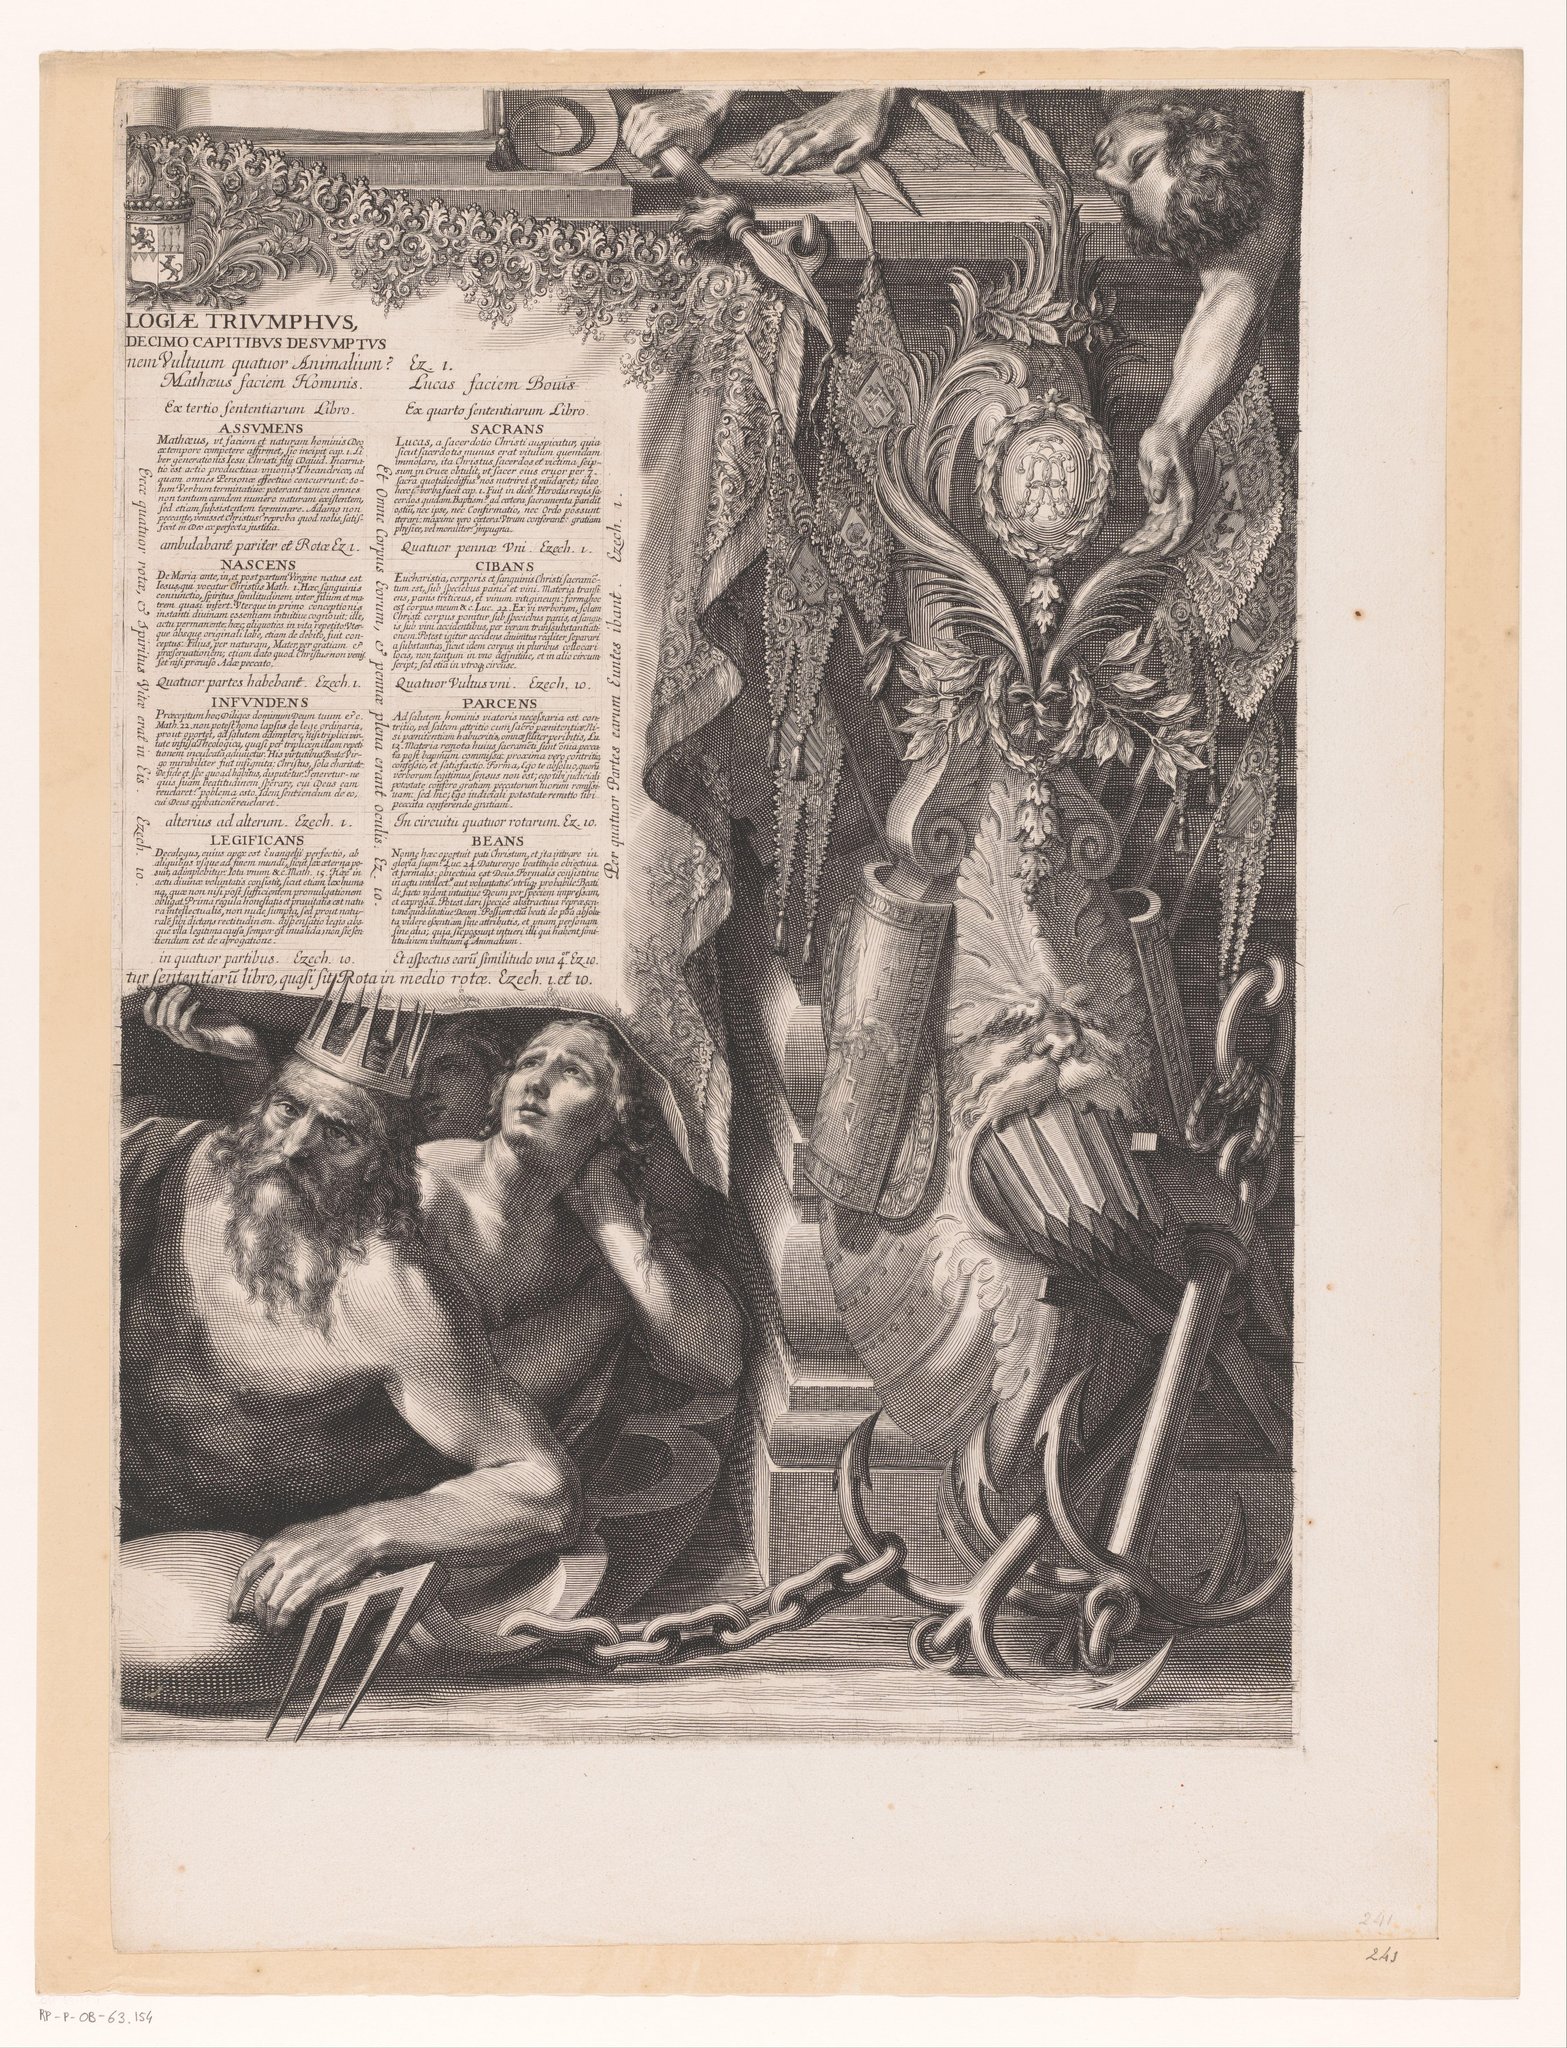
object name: print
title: Allegorische voorstelling met Armand-Jean du Plessis hertog van Richelieu, in het gezelschap van Apollo en Neptunus (deel rechtsonder)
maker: grégoire huret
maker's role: print maker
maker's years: 1606-1670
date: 1616-1670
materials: paper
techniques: engraving, etching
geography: france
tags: paris, armand-jean du plessis hertog van richelieu, (story of) neptune (poseidon), offspring, companion(s), train etc. of neptune, historical persons, armorial bearing, heraldry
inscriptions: collector's mark: Lugt 240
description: Rechter onderzijde van een allegorische voorstelling met linksboven het portret van Armand-Jean du Plessis hertog van Richelieu, gezeten op een stoel met rechts van hem muzen of nimfen die hem verschillende wapenschilden aanreiken. In het midden staat Apollo met zijn lier met achter hem een doorkijk naar buiten, waar de mast van een schip is te zien. Boven hem vliegen engelen of putti met portretten van verschillende figuren. Rechts van Apollo bevinden zich verschillende figuren (waaronder mogelijk Hercules) die een leeuw bevechten. Midden onder ligt Neptunus ten midden van ankers zijn gevolg.